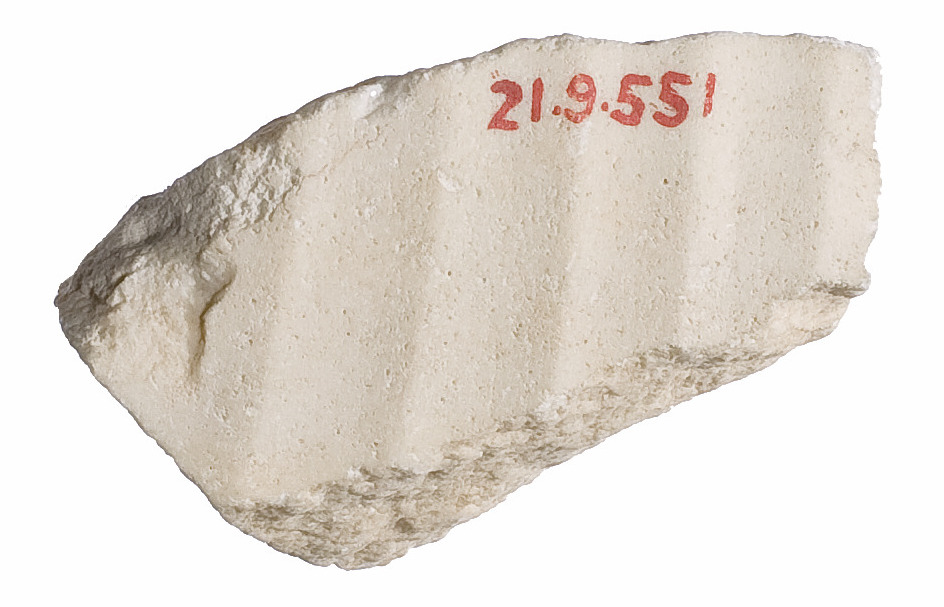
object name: body with garment, pleating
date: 1353-1336 BCE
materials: limestone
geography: egypt